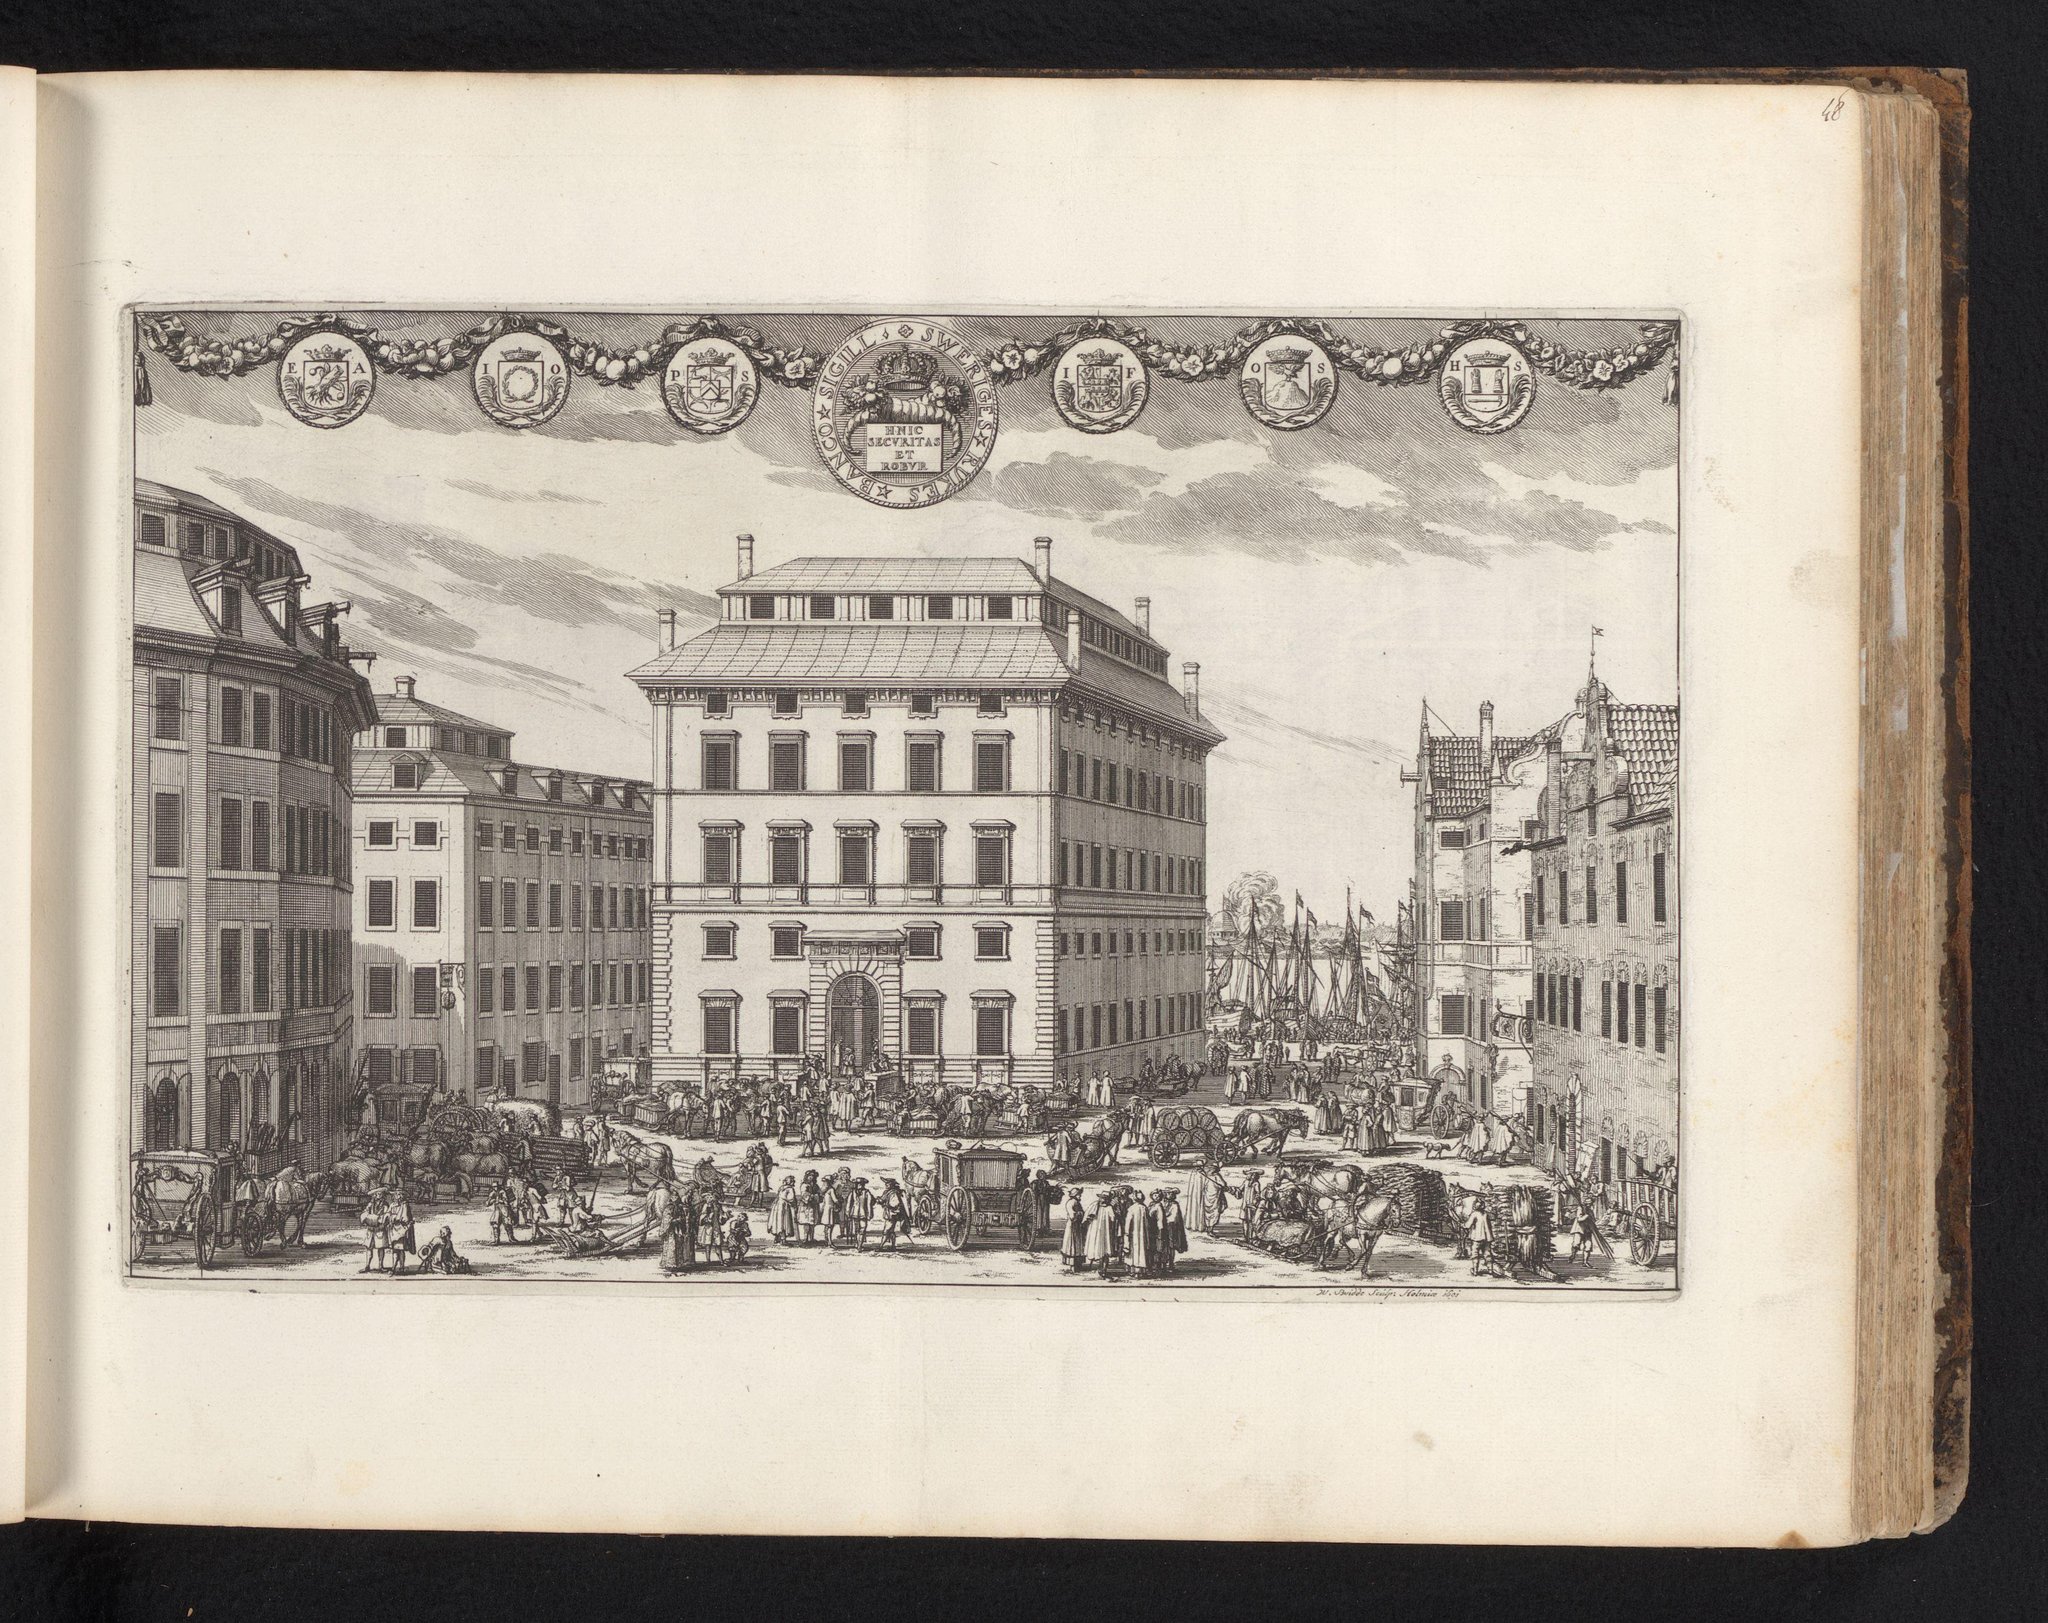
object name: print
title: Suecia Antiqua et Hodierna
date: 1691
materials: paper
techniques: etching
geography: stockholm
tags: bank, village square, place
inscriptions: date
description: De Zuidelijke Nationale Bank aan het Järntorget plein in Stockholm. Daarachter een haven met schepen. De prent maakt deel uit van een album.